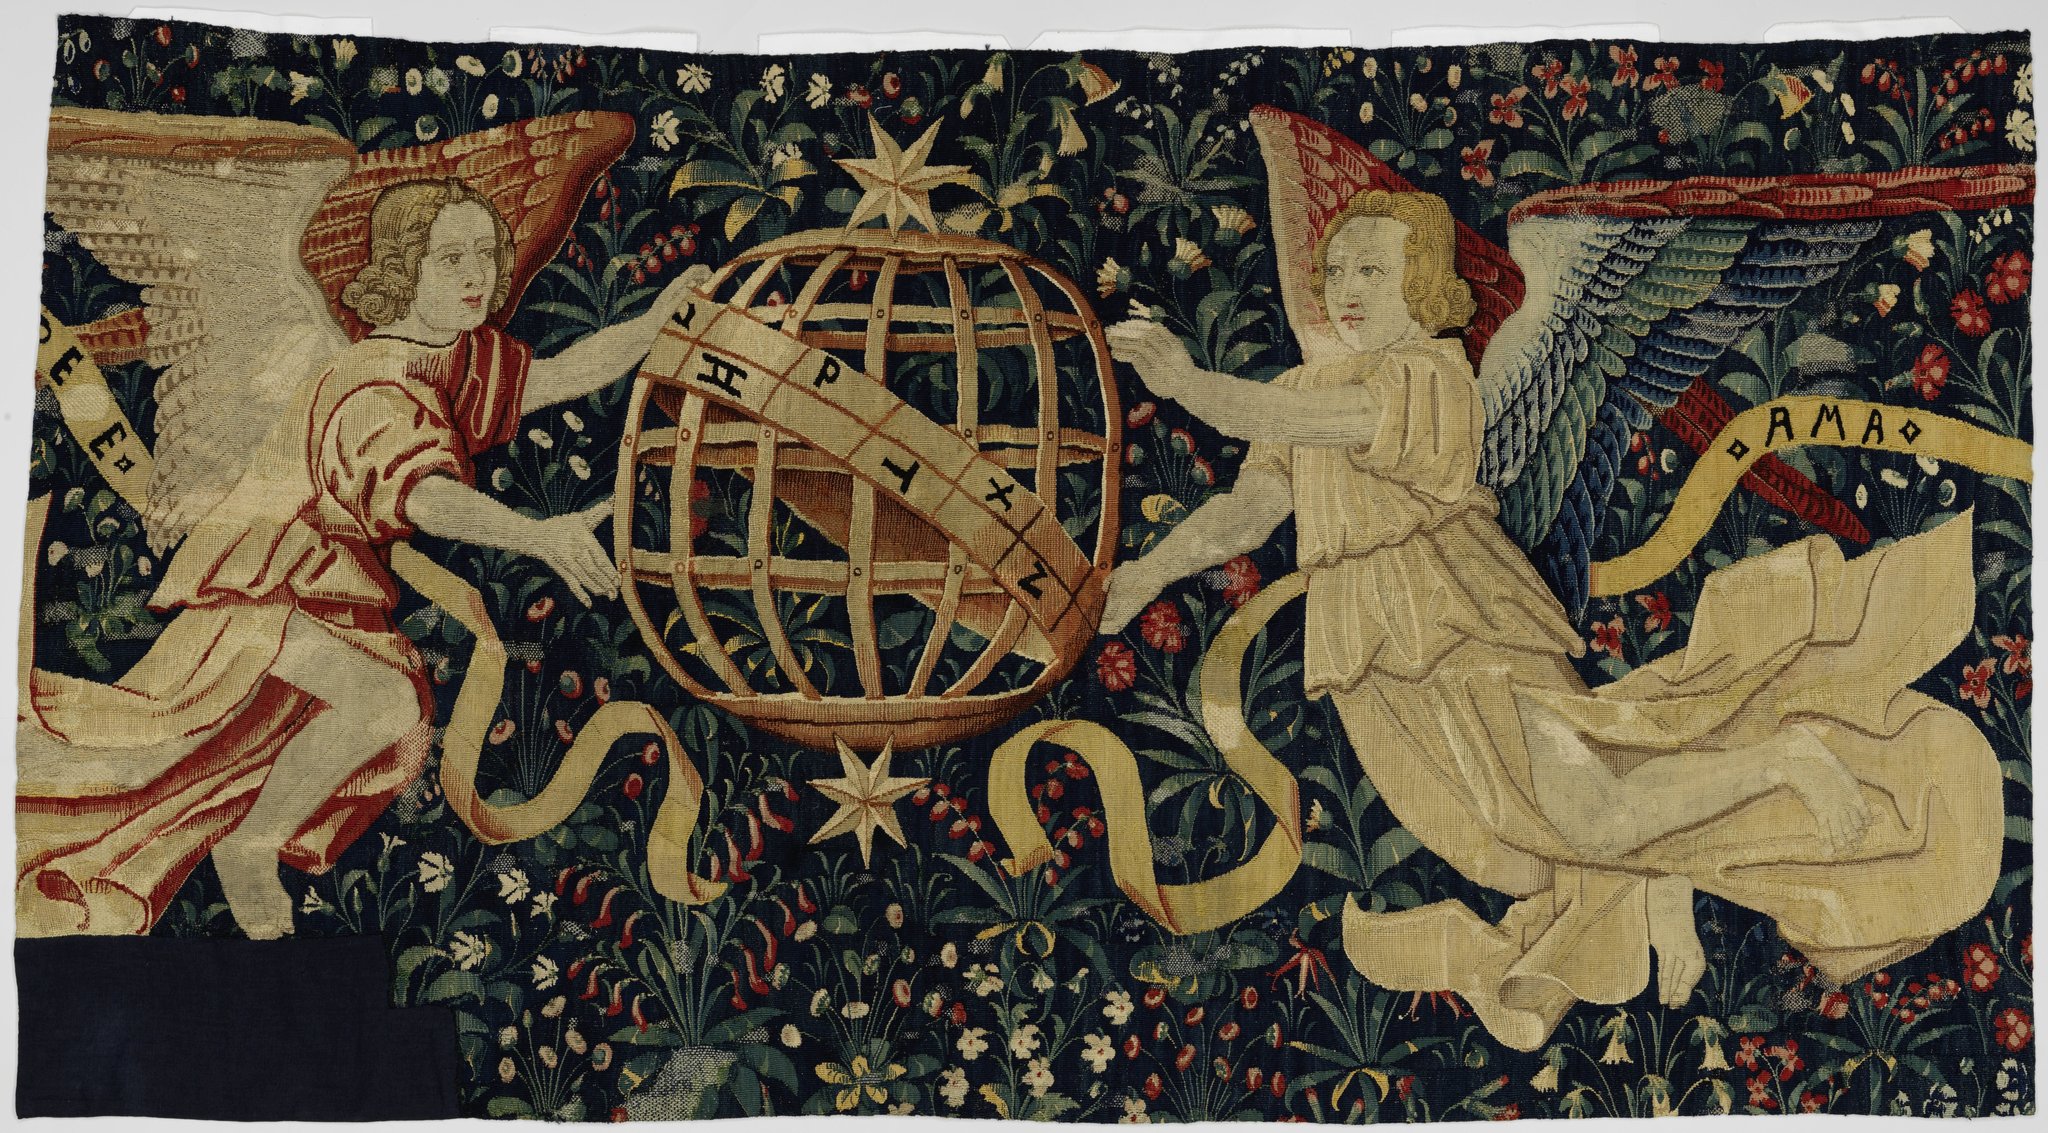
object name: tapestry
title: Millefleurs met de engelen van geloof en liefde die een armilliairsfeer vasthouden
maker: Anonymous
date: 1500-1525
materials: silk, wool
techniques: tapestry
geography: southern netherlands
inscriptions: : ‘AMA’, : ‘[CR]E[D]E’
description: Tapestry (fragment). A celestial globe borne by angels. Wool, silk. Southern Netherlands, c. 1475 - 1500.